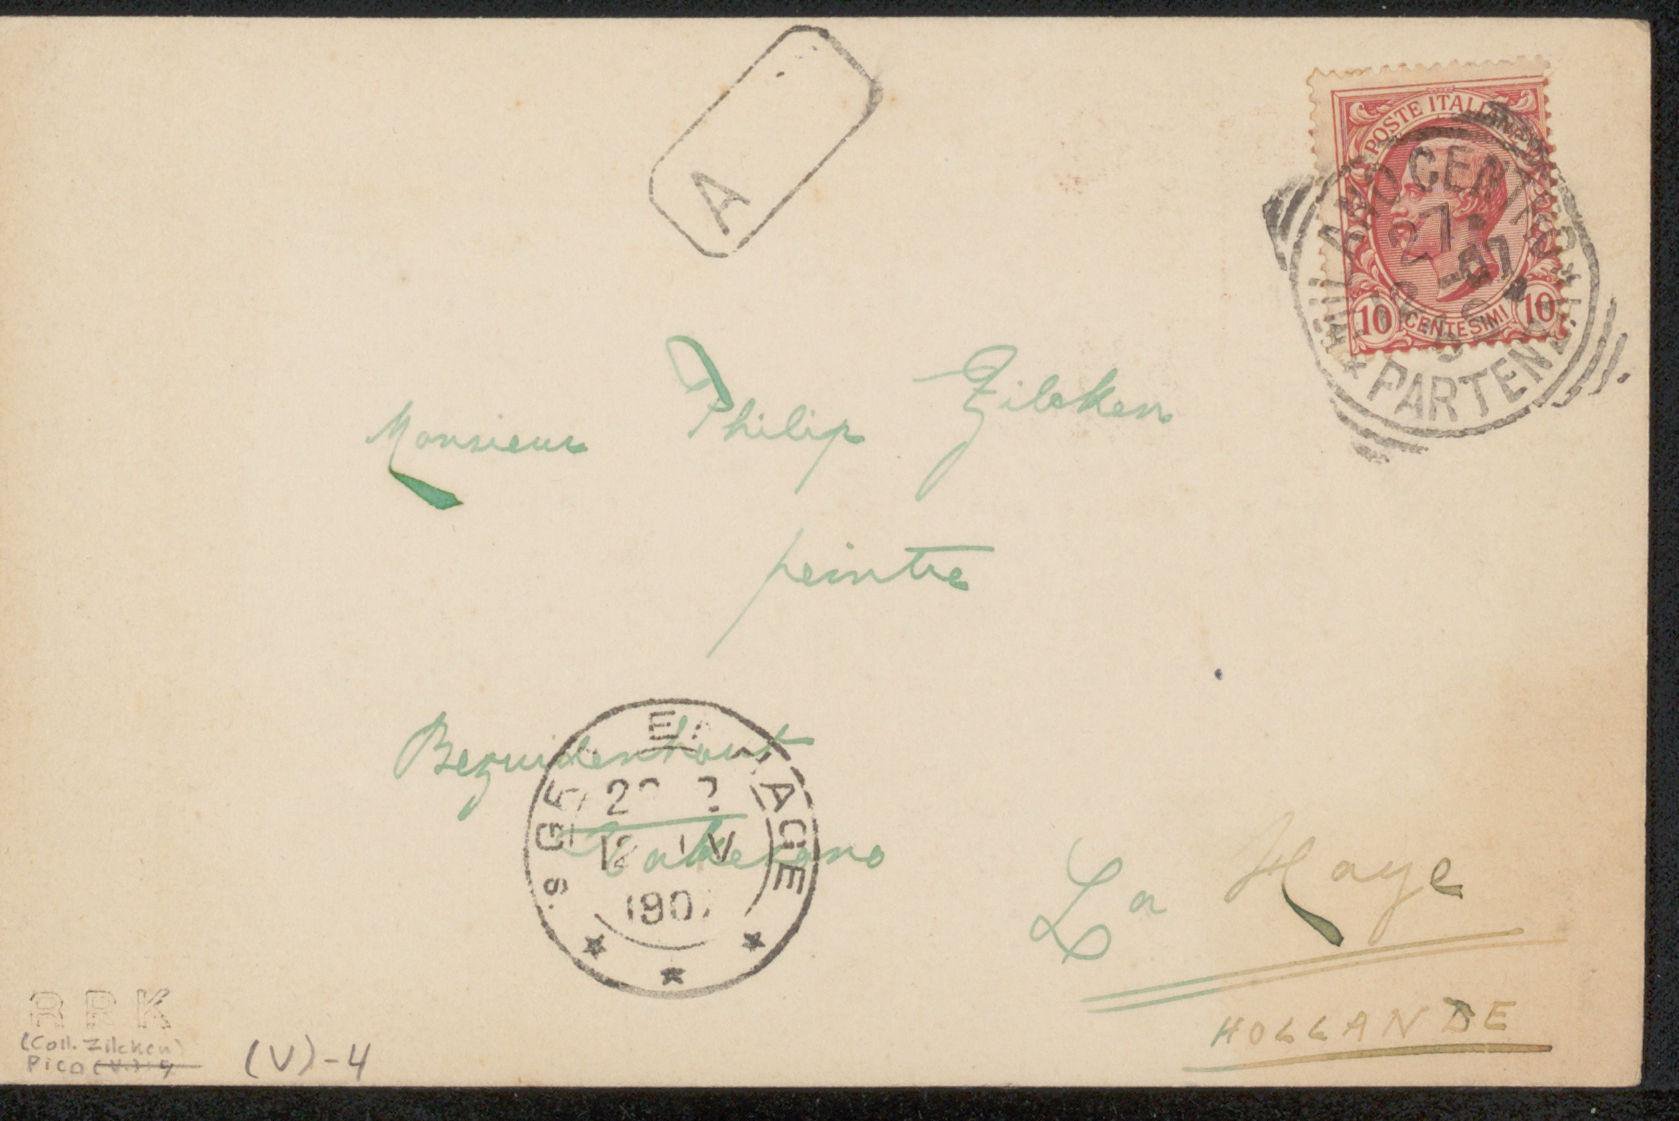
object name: letter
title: Brief aan Philip Zilcken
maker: vittorio pica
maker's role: criticus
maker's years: 1864-1930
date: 1907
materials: cardboard, ink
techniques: pen, printing, writing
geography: milan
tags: painter, draughtsman, philip zilcken, exhibition ~ art, printed matter, brussels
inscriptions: collector's mark: ‘RPK’